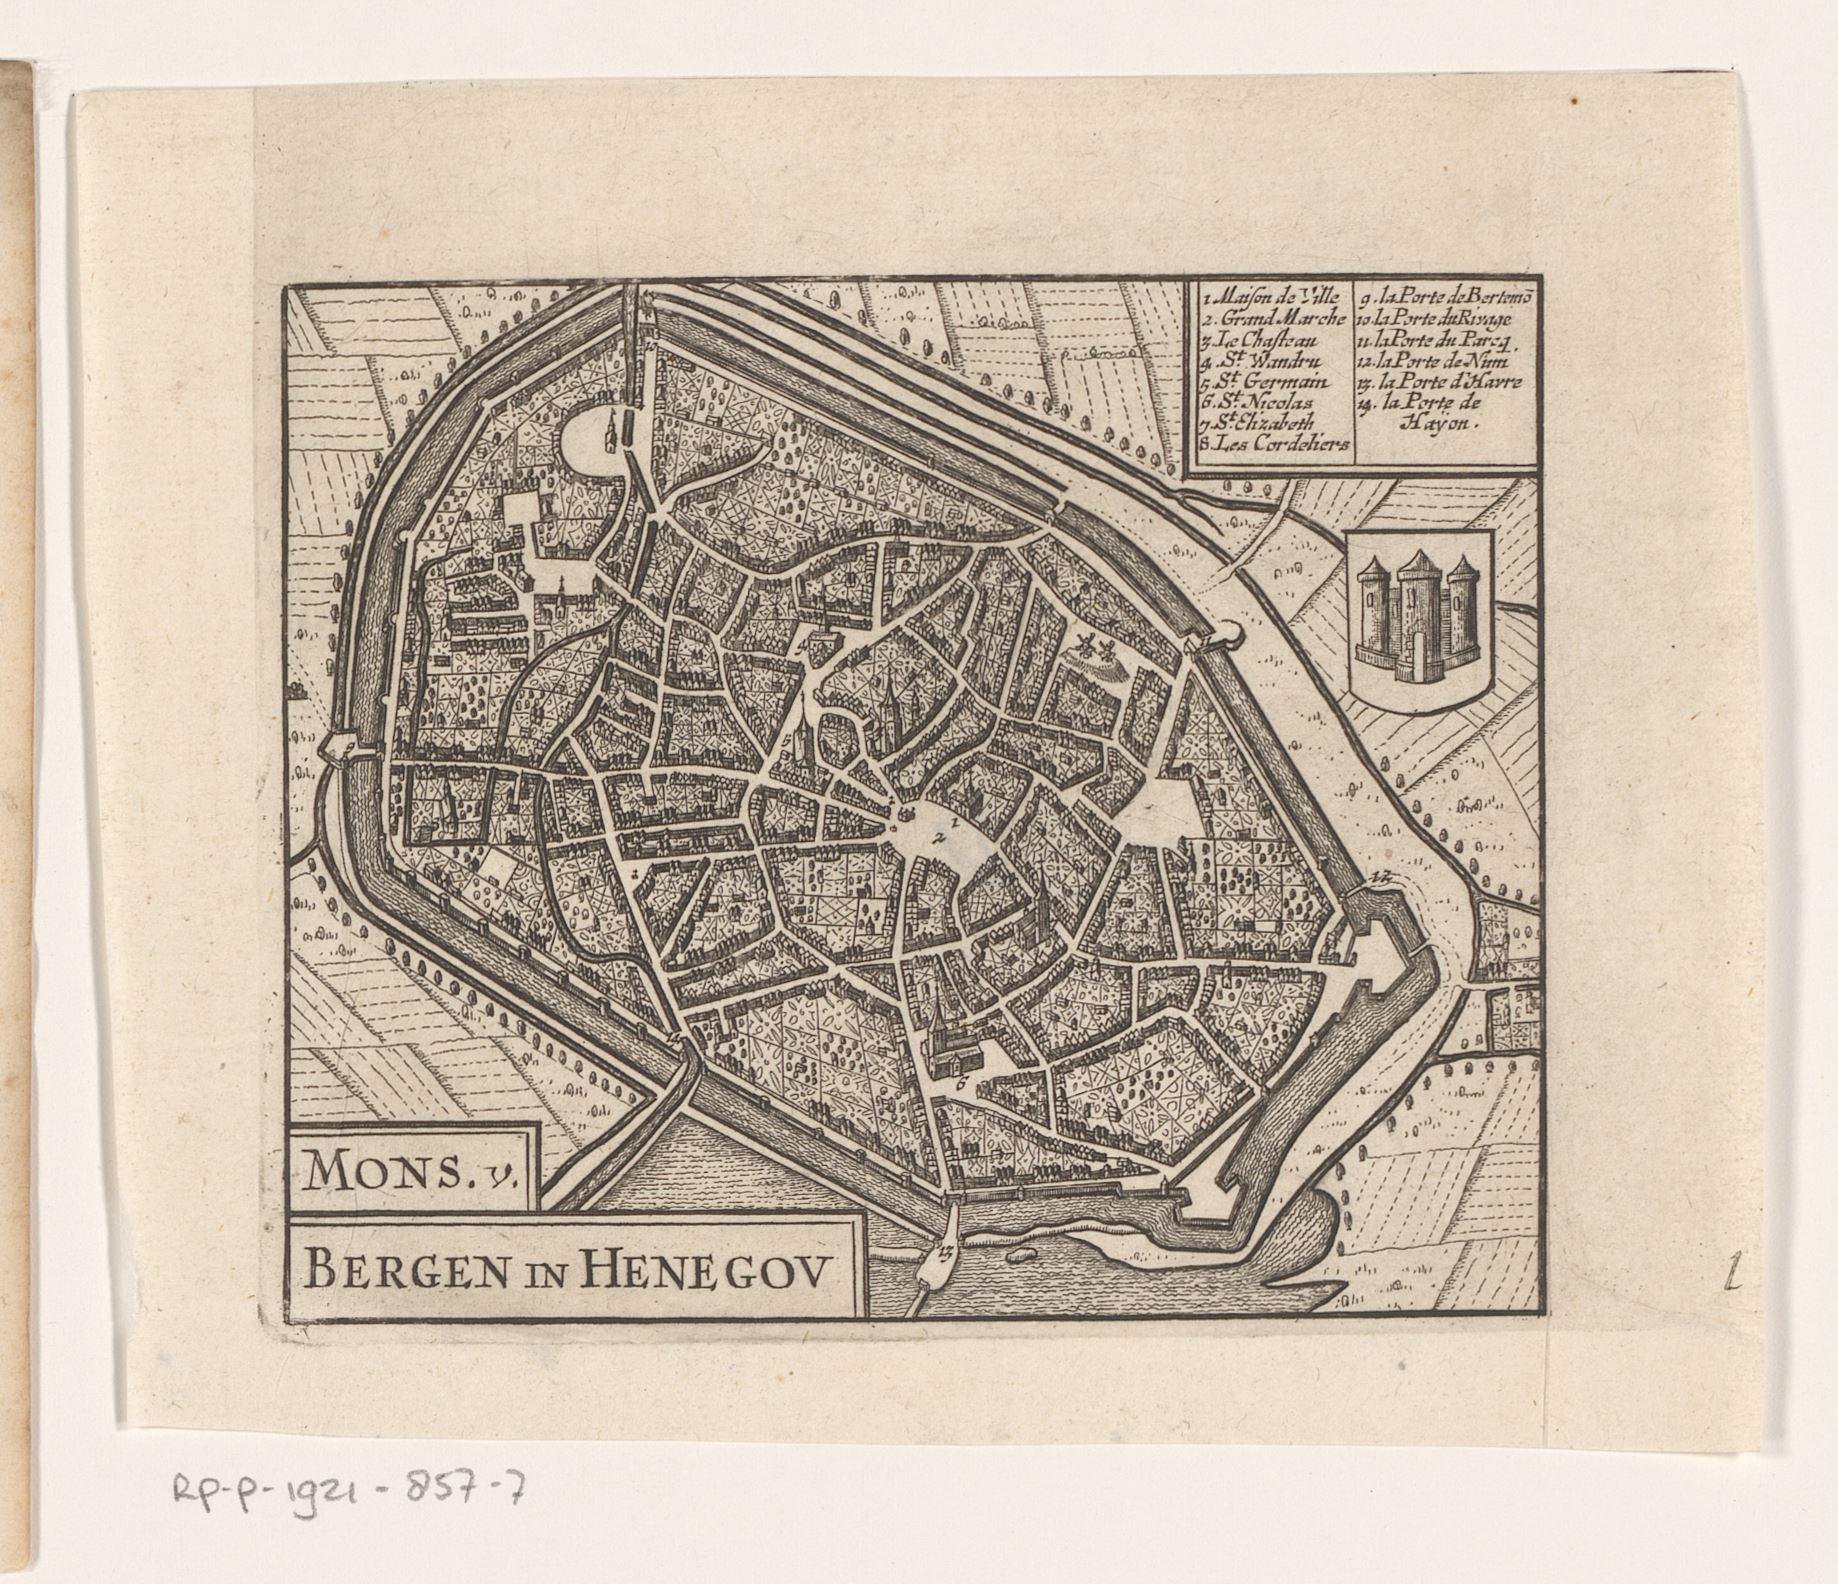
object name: area plan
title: Plattegrond van Mons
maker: Anonymous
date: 1652-1662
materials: paper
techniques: etching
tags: maps of cities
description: Plattegrond maakt onderdeel uit van een prent met meerdere plattegronden: Alkmaar, Aalst, Amsterdam, Antwerpen, Mons (Bergen), Utrecht, Bergen op Zoom en Arnhem. Prent onder andere verschenen in: Guicciardini, Lodovico. Belgicae sive Inferioris Germaniae (...). Amsterdam: Jacob van Meurs, 1660. En in: Guicciardini, Lodovico. Belgicae sive Inferioris Germaniae (...). Amsterdam: Johannes Janssonius, 1652.